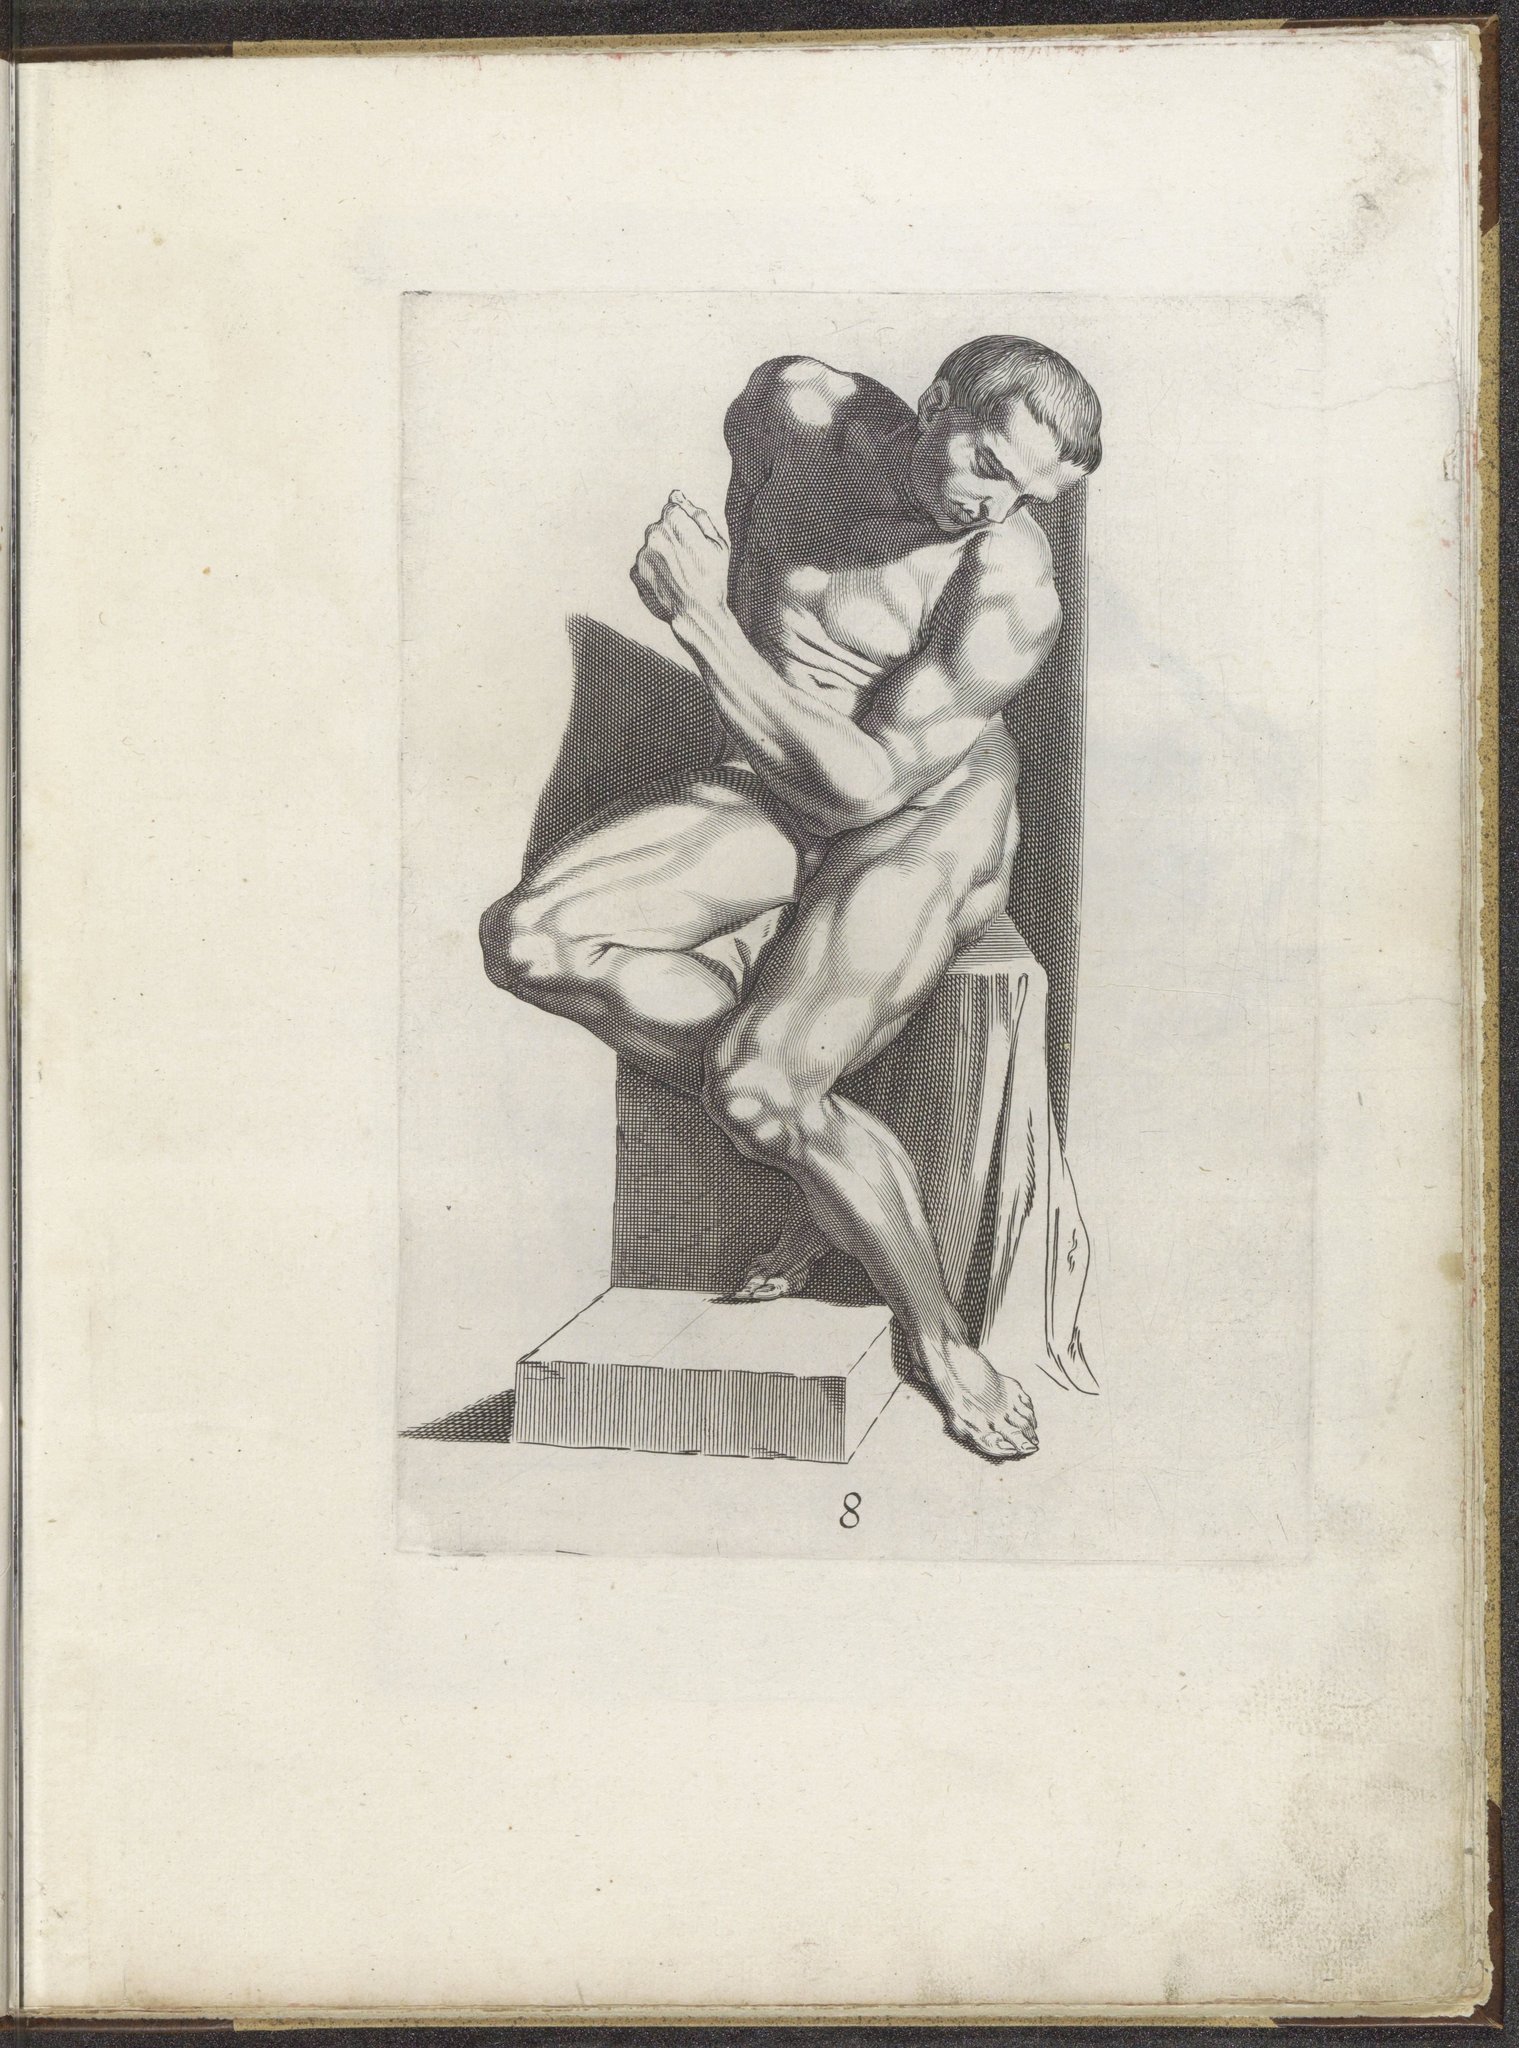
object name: album leaf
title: Varie figvre academiche / Diversche figvren wt de academia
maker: pieter de jode (i)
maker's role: draughtsman, print maker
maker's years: 1570-1634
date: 1629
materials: paper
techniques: engraving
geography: antwerp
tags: human figure of ideal proportions, e.g. academic nude, sitting on an elevation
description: Tekenvoorbeeld van een zittend mannelijk naakt met gebalde vuist. Deze prent maakt deel uit van een album.